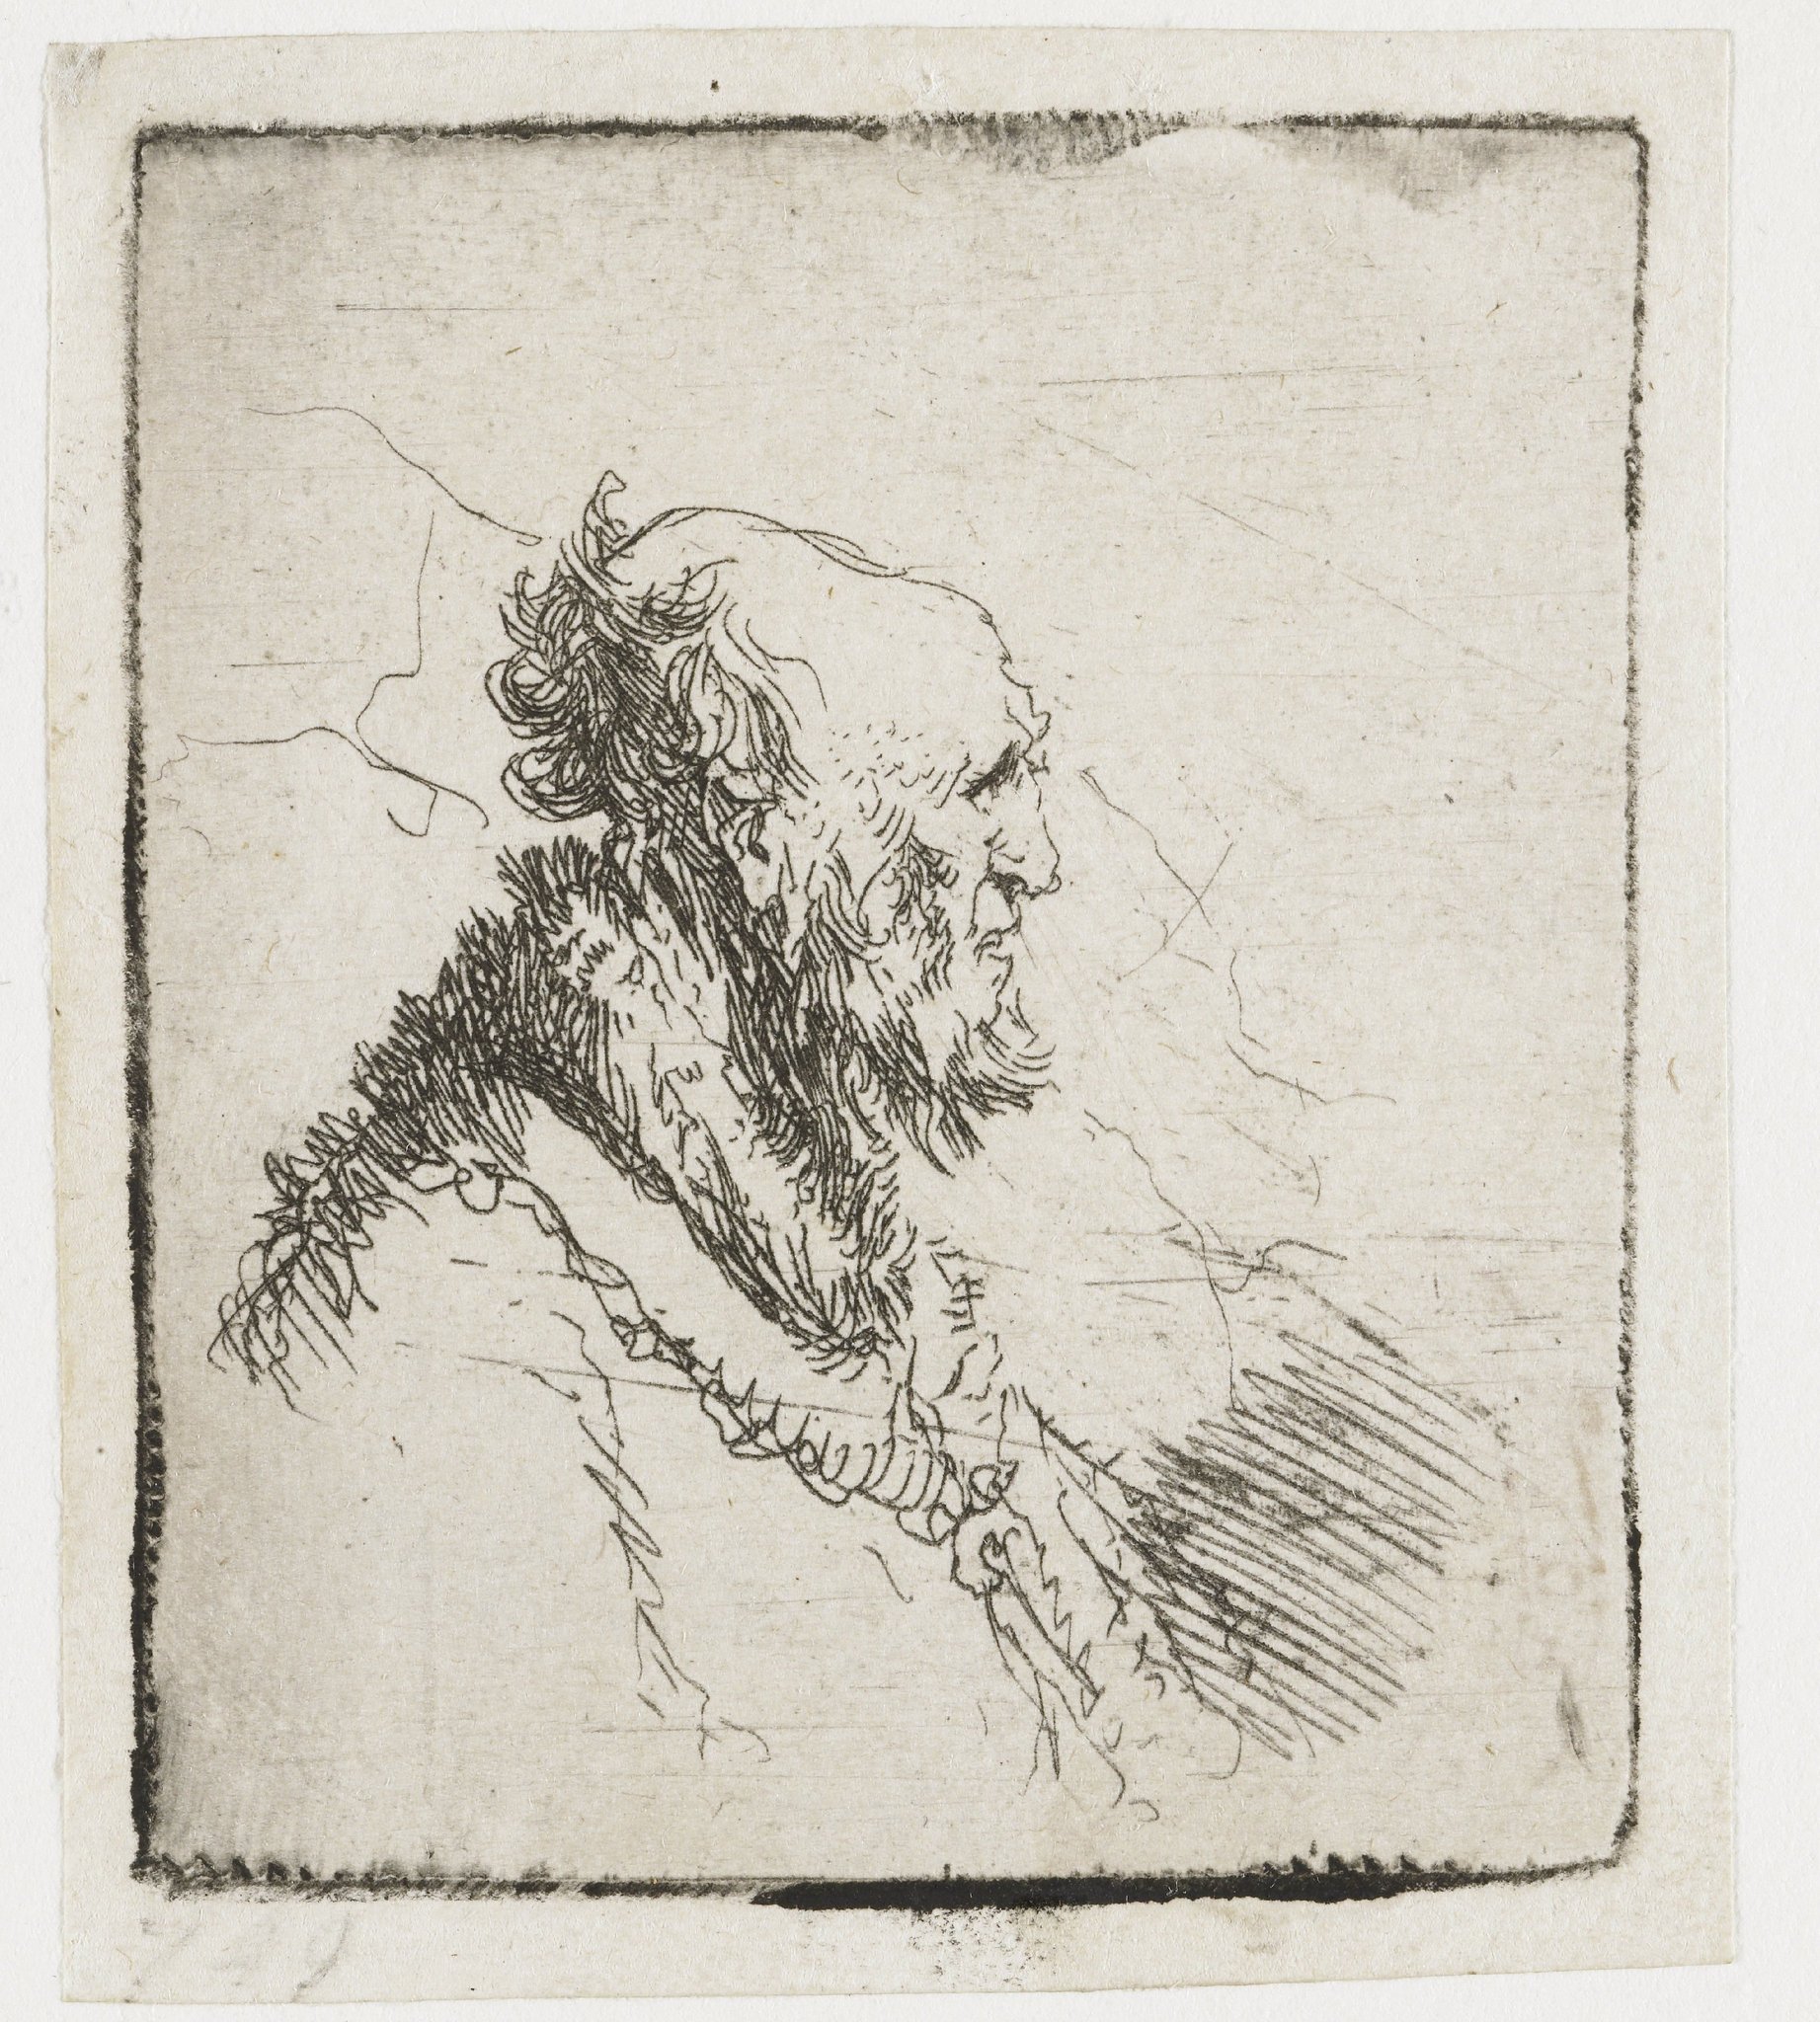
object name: print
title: Bald Old Man with a Short Beard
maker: rembrandt van rijn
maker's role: draughtsman, painter, print maker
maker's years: 1606-1669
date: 1635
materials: paper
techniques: etching, intaglio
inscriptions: collector's mark: Lugt 240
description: The numerous old men that Rembrandt etched in his early years in Leiden will have regularly posed for him while seated in a chair. This is rarely visible in his prints, but is so in this one. The shabbily attired old man with a patchy beard and bony hands stands out slightly against the large armchair in which he sits. This chair lends him an air of near biblical grandeur.